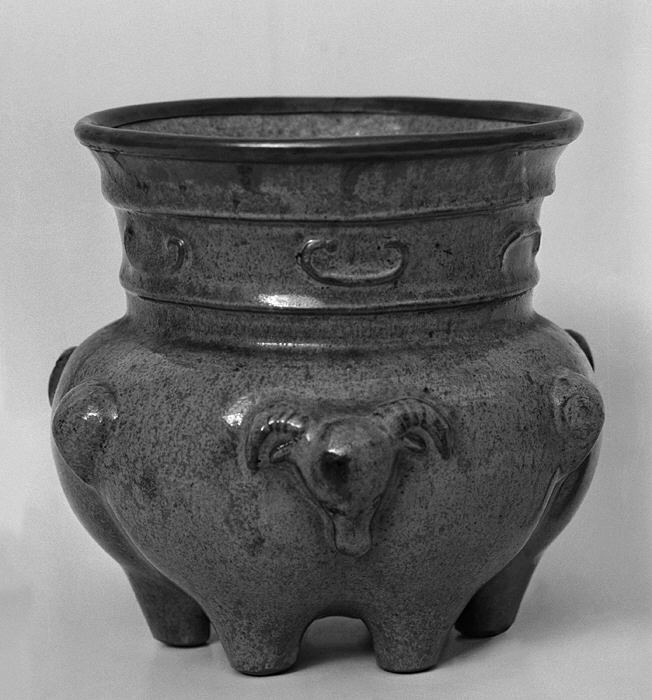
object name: vessel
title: Tripod vessel with three ram heads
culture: chinese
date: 1701-1800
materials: copper alloy, glaze, stoneware